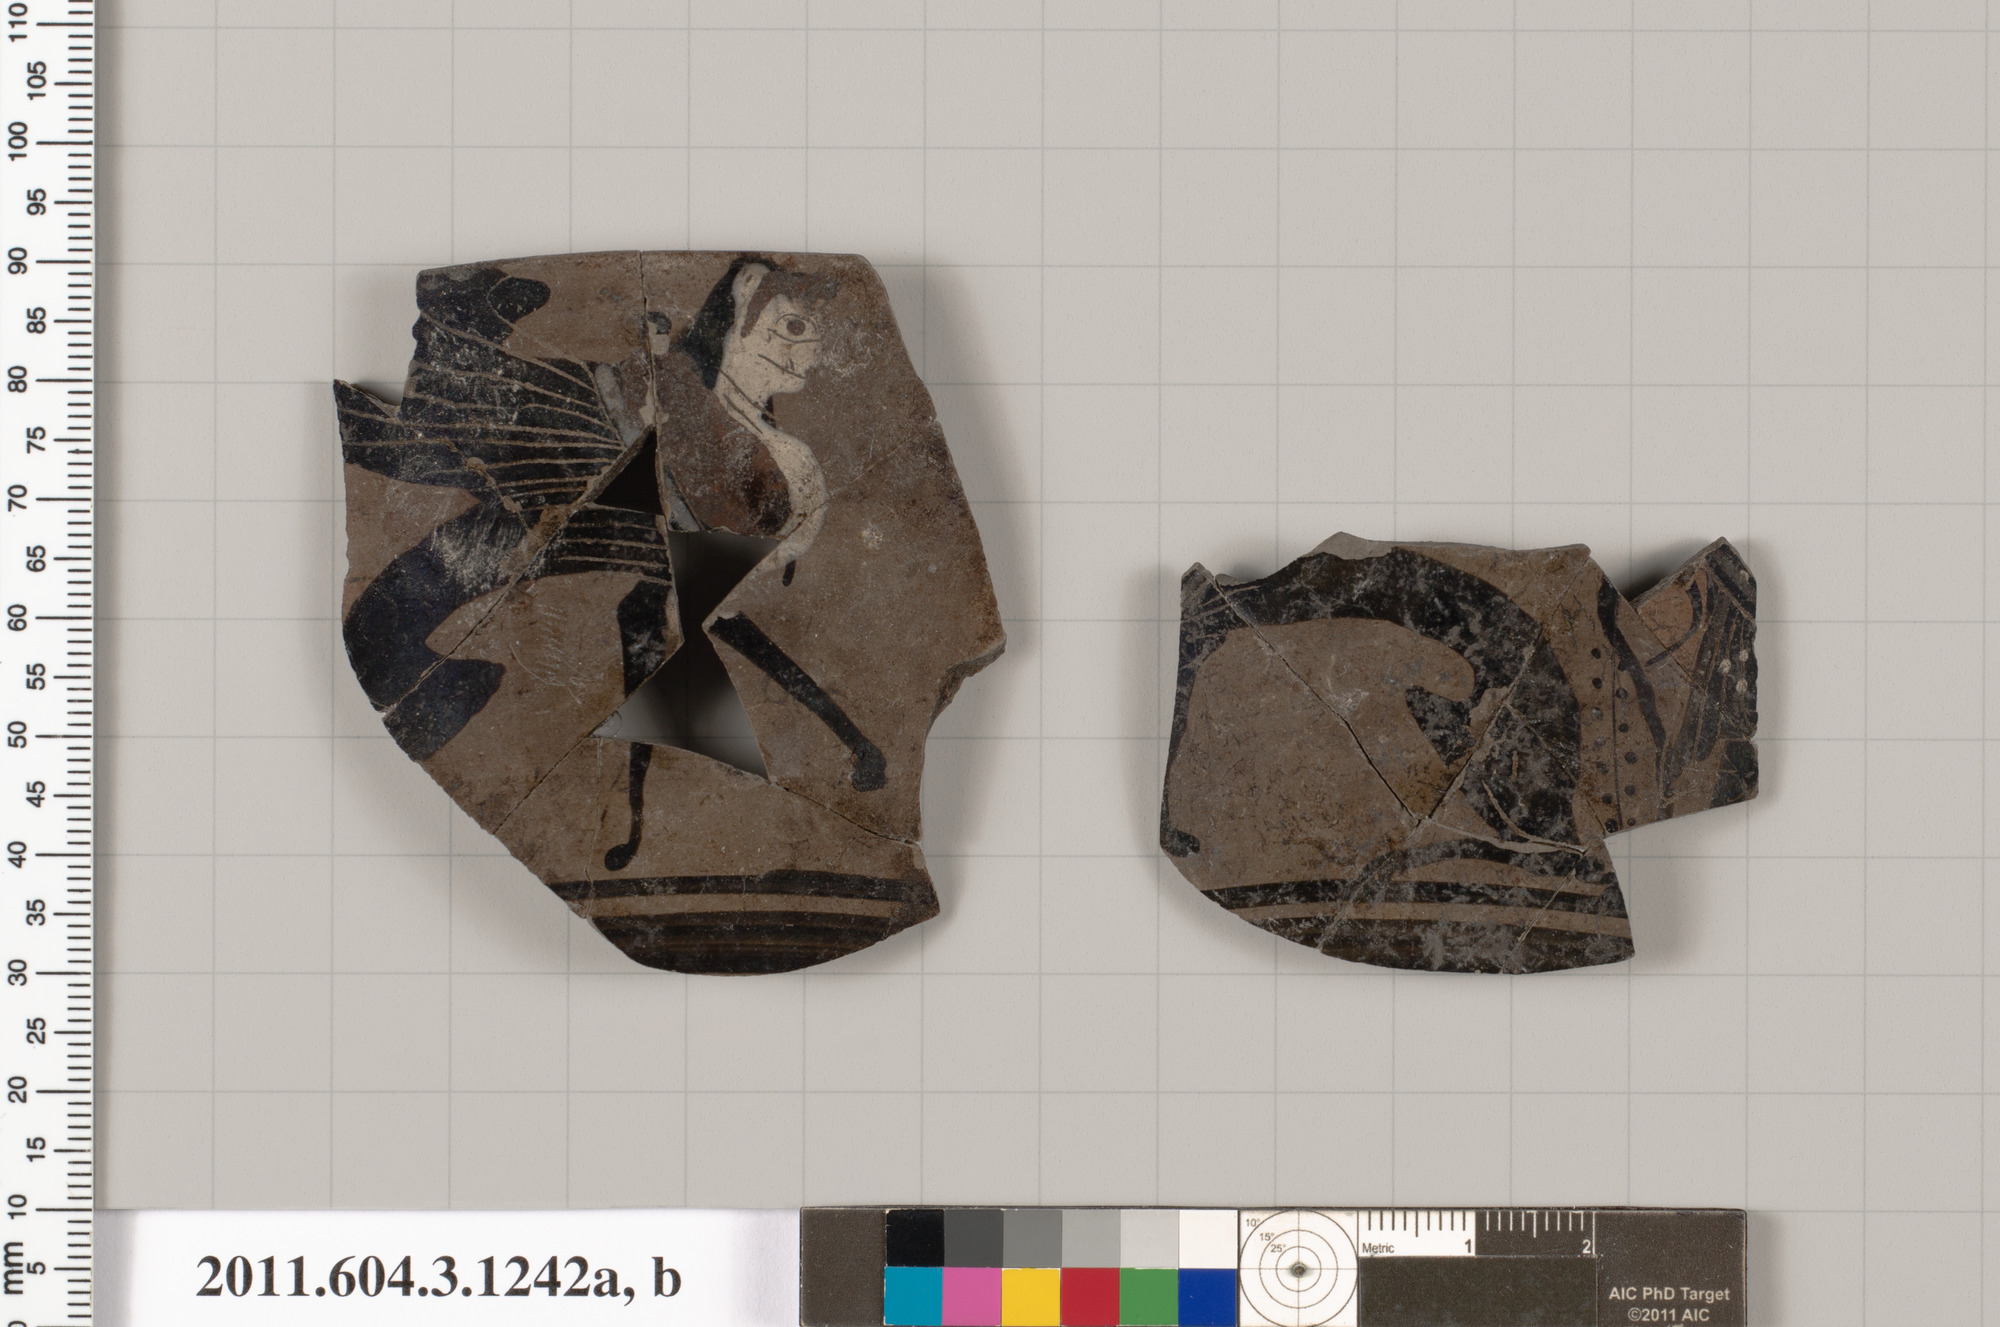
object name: kyathos fragment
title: Terracotta fragments of a kyathos (cup-shaped ladle)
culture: greek, attic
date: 534-468 BCE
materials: terracotta